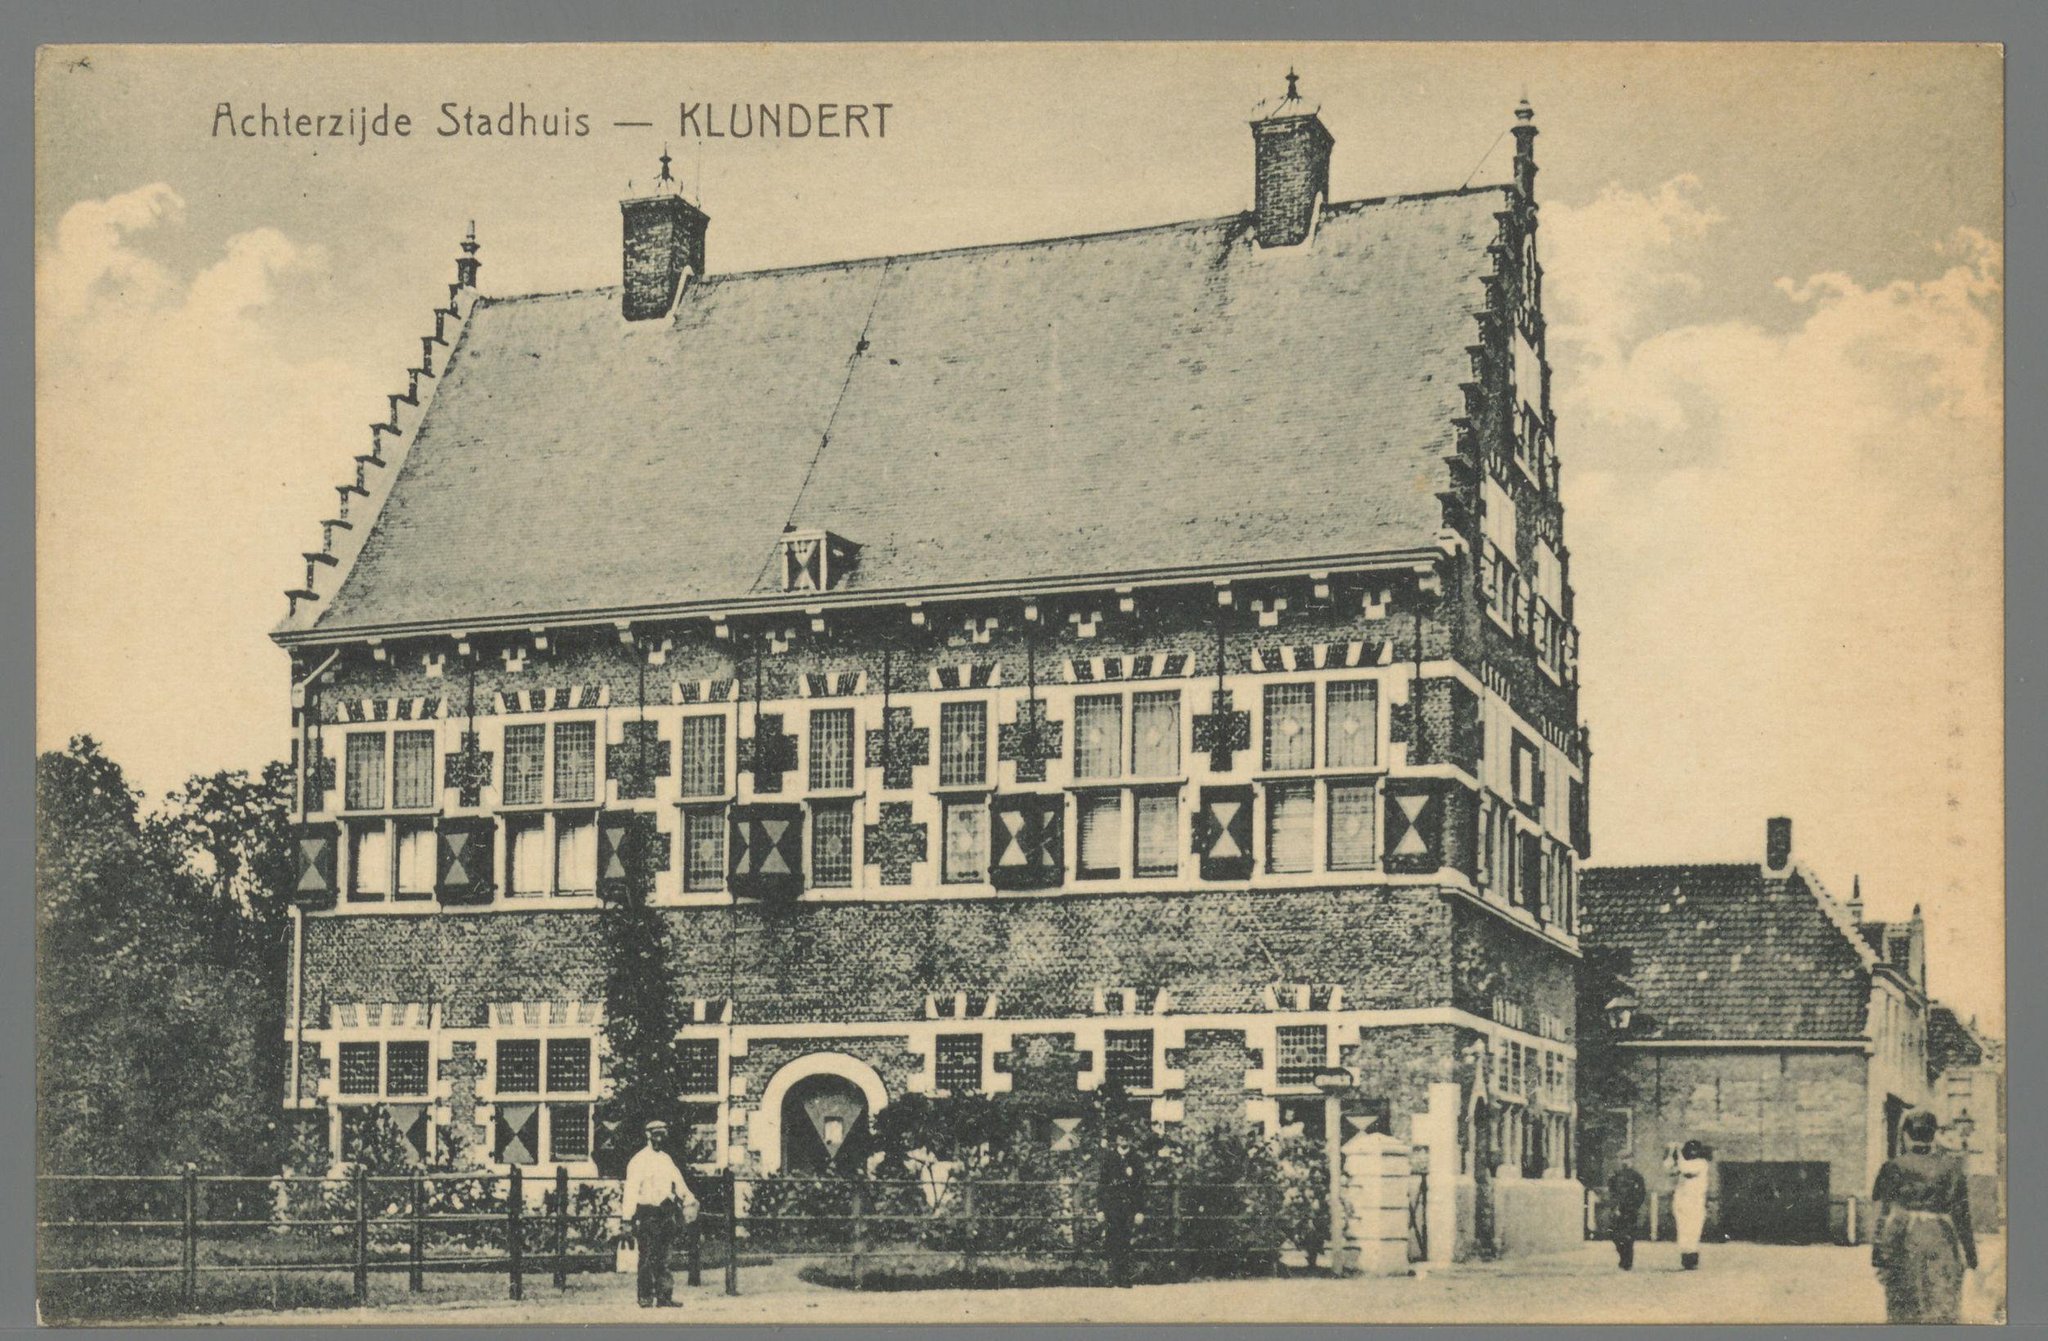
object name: ansichtkaart, prentbriefkaart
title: Achterzijde Stadhuis - Klundert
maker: Anonymous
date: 1920-1930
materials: cardboard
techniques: photograph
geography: klundert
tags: townhall